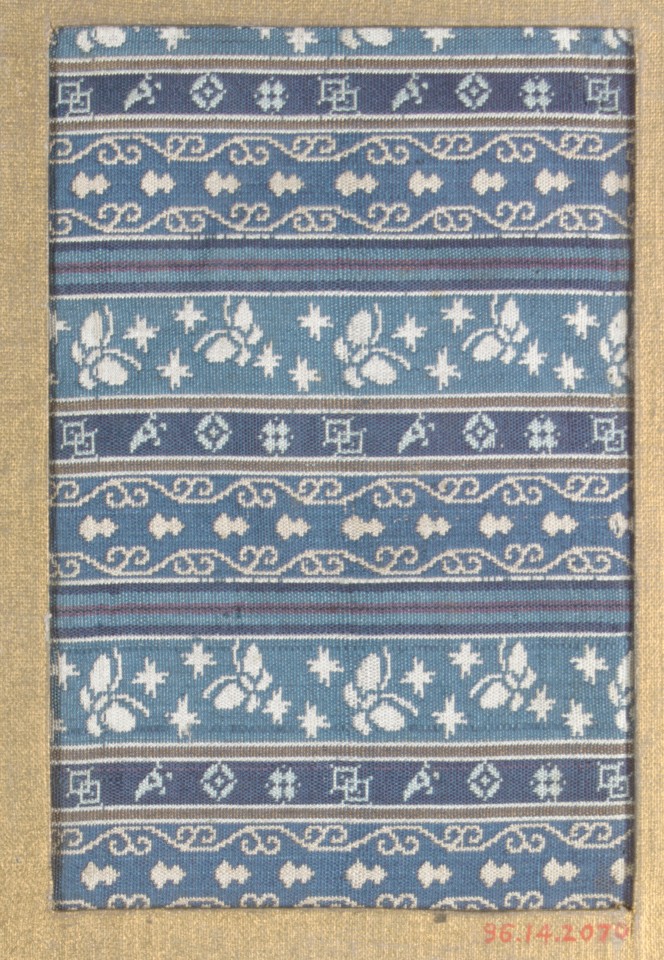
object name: piece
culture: japanese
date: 1701-1900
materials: silk